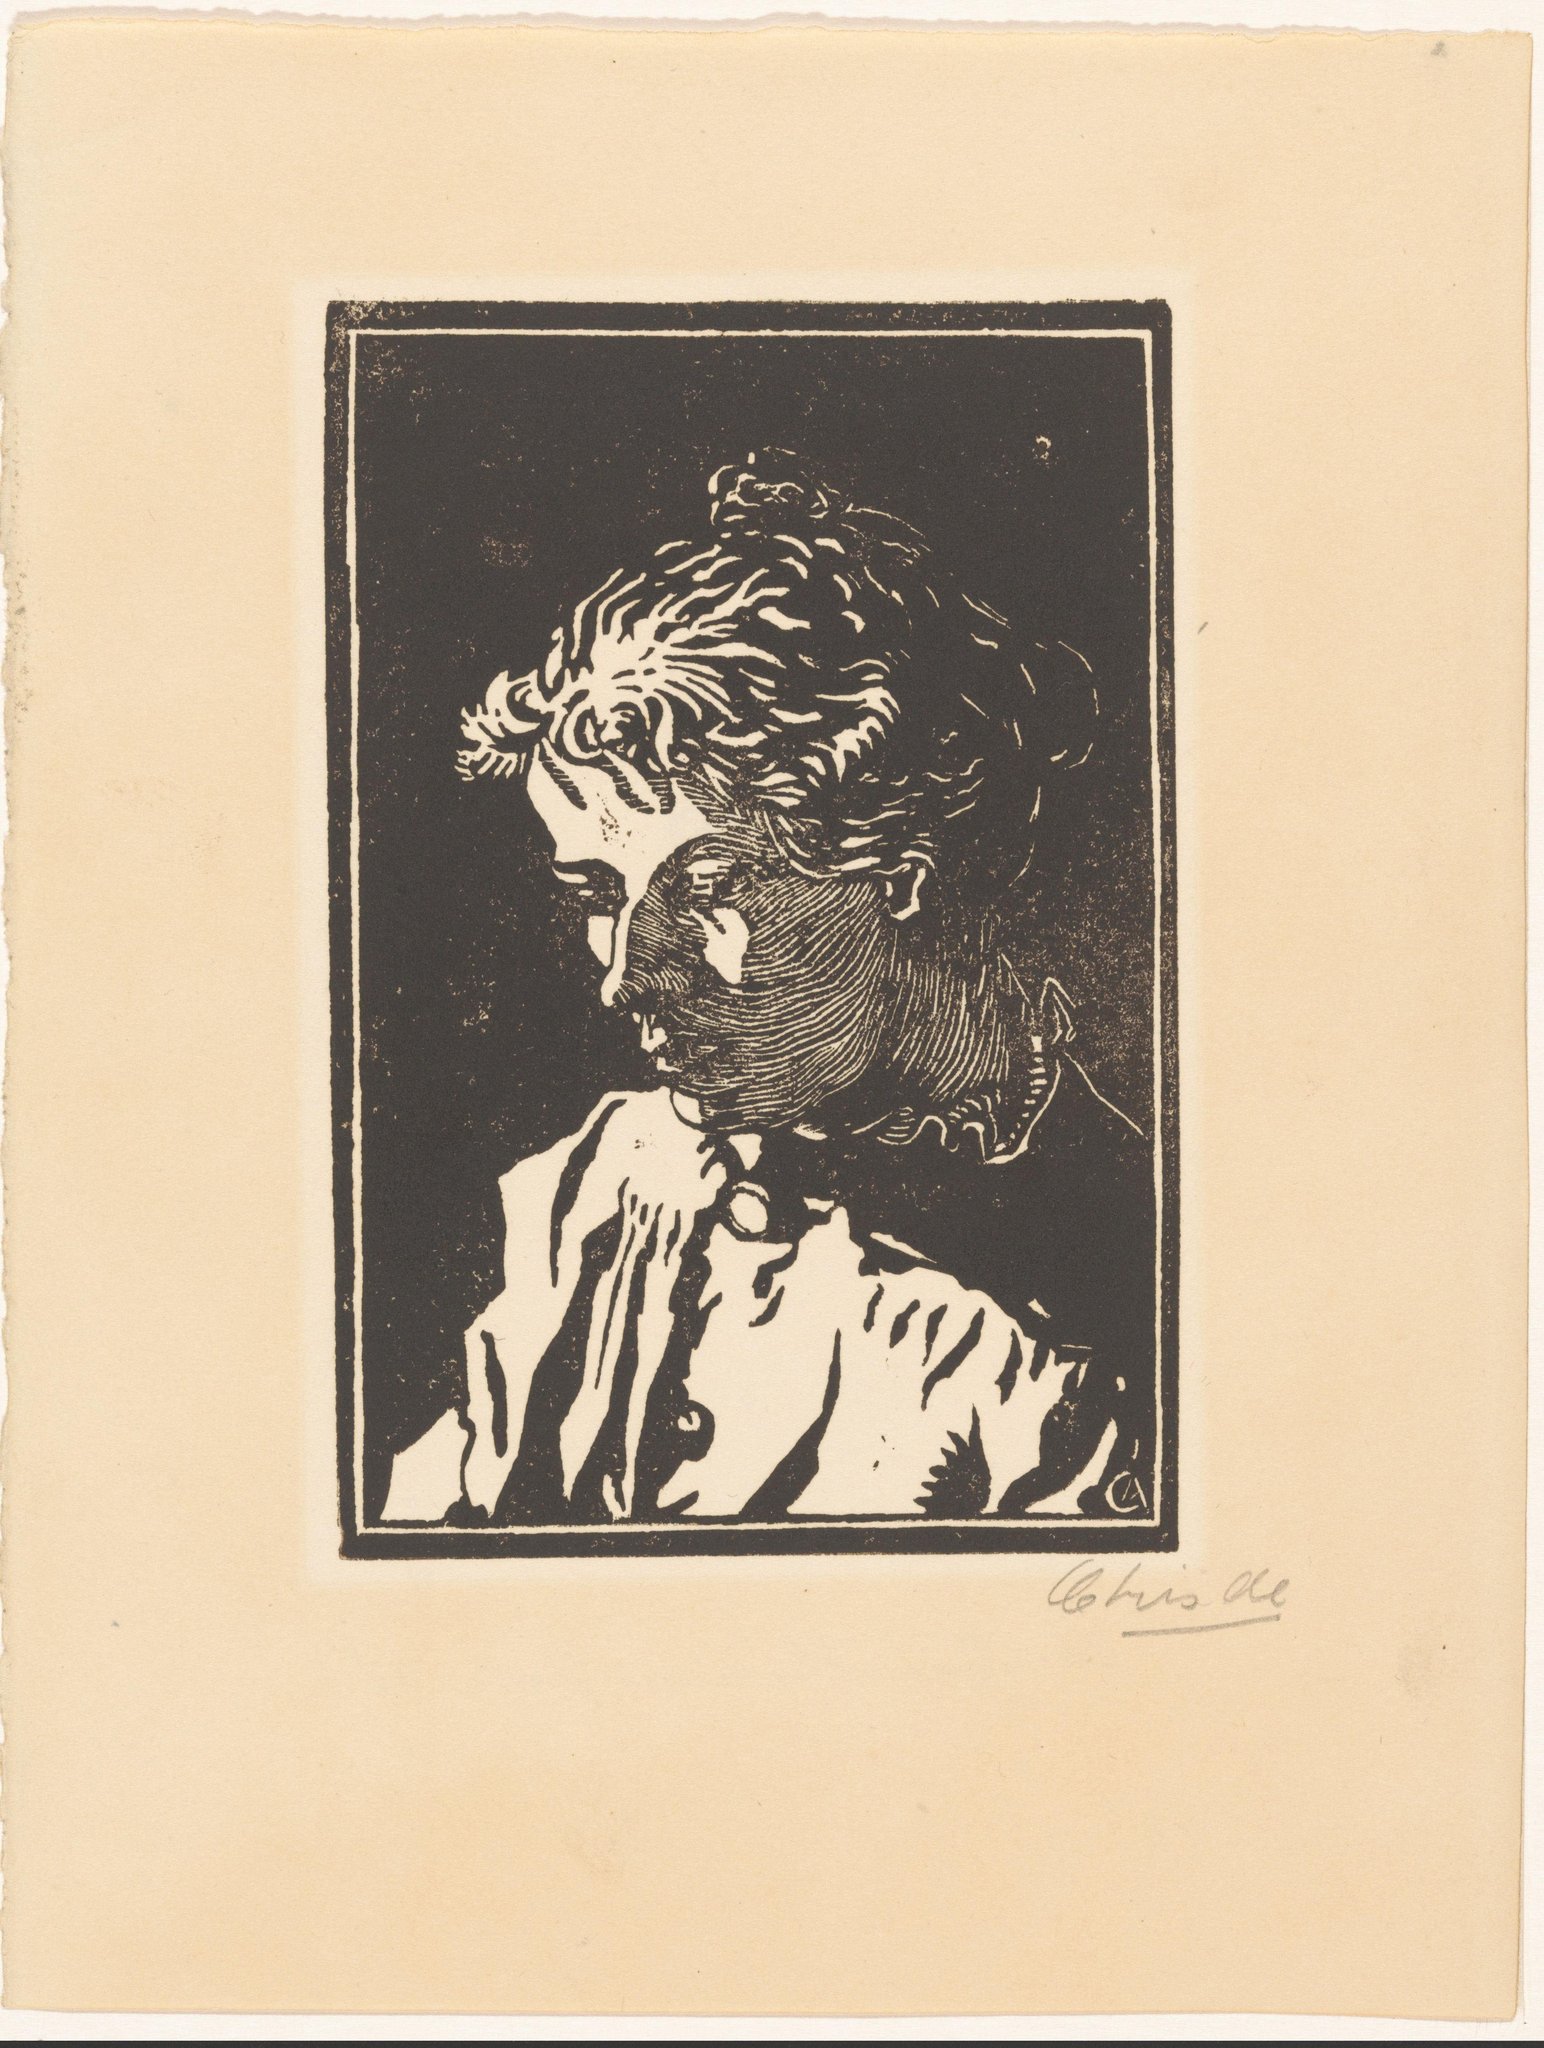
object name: print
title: Naar beneden kijkende vrouw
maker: chris al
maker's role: print maker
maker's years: 1885-1954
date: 1895-1935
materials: paper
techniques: woodcut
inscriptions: signature: ‘Chris Al’, collector's mark: Lugt 2760, collector's mark: Lugt 2228